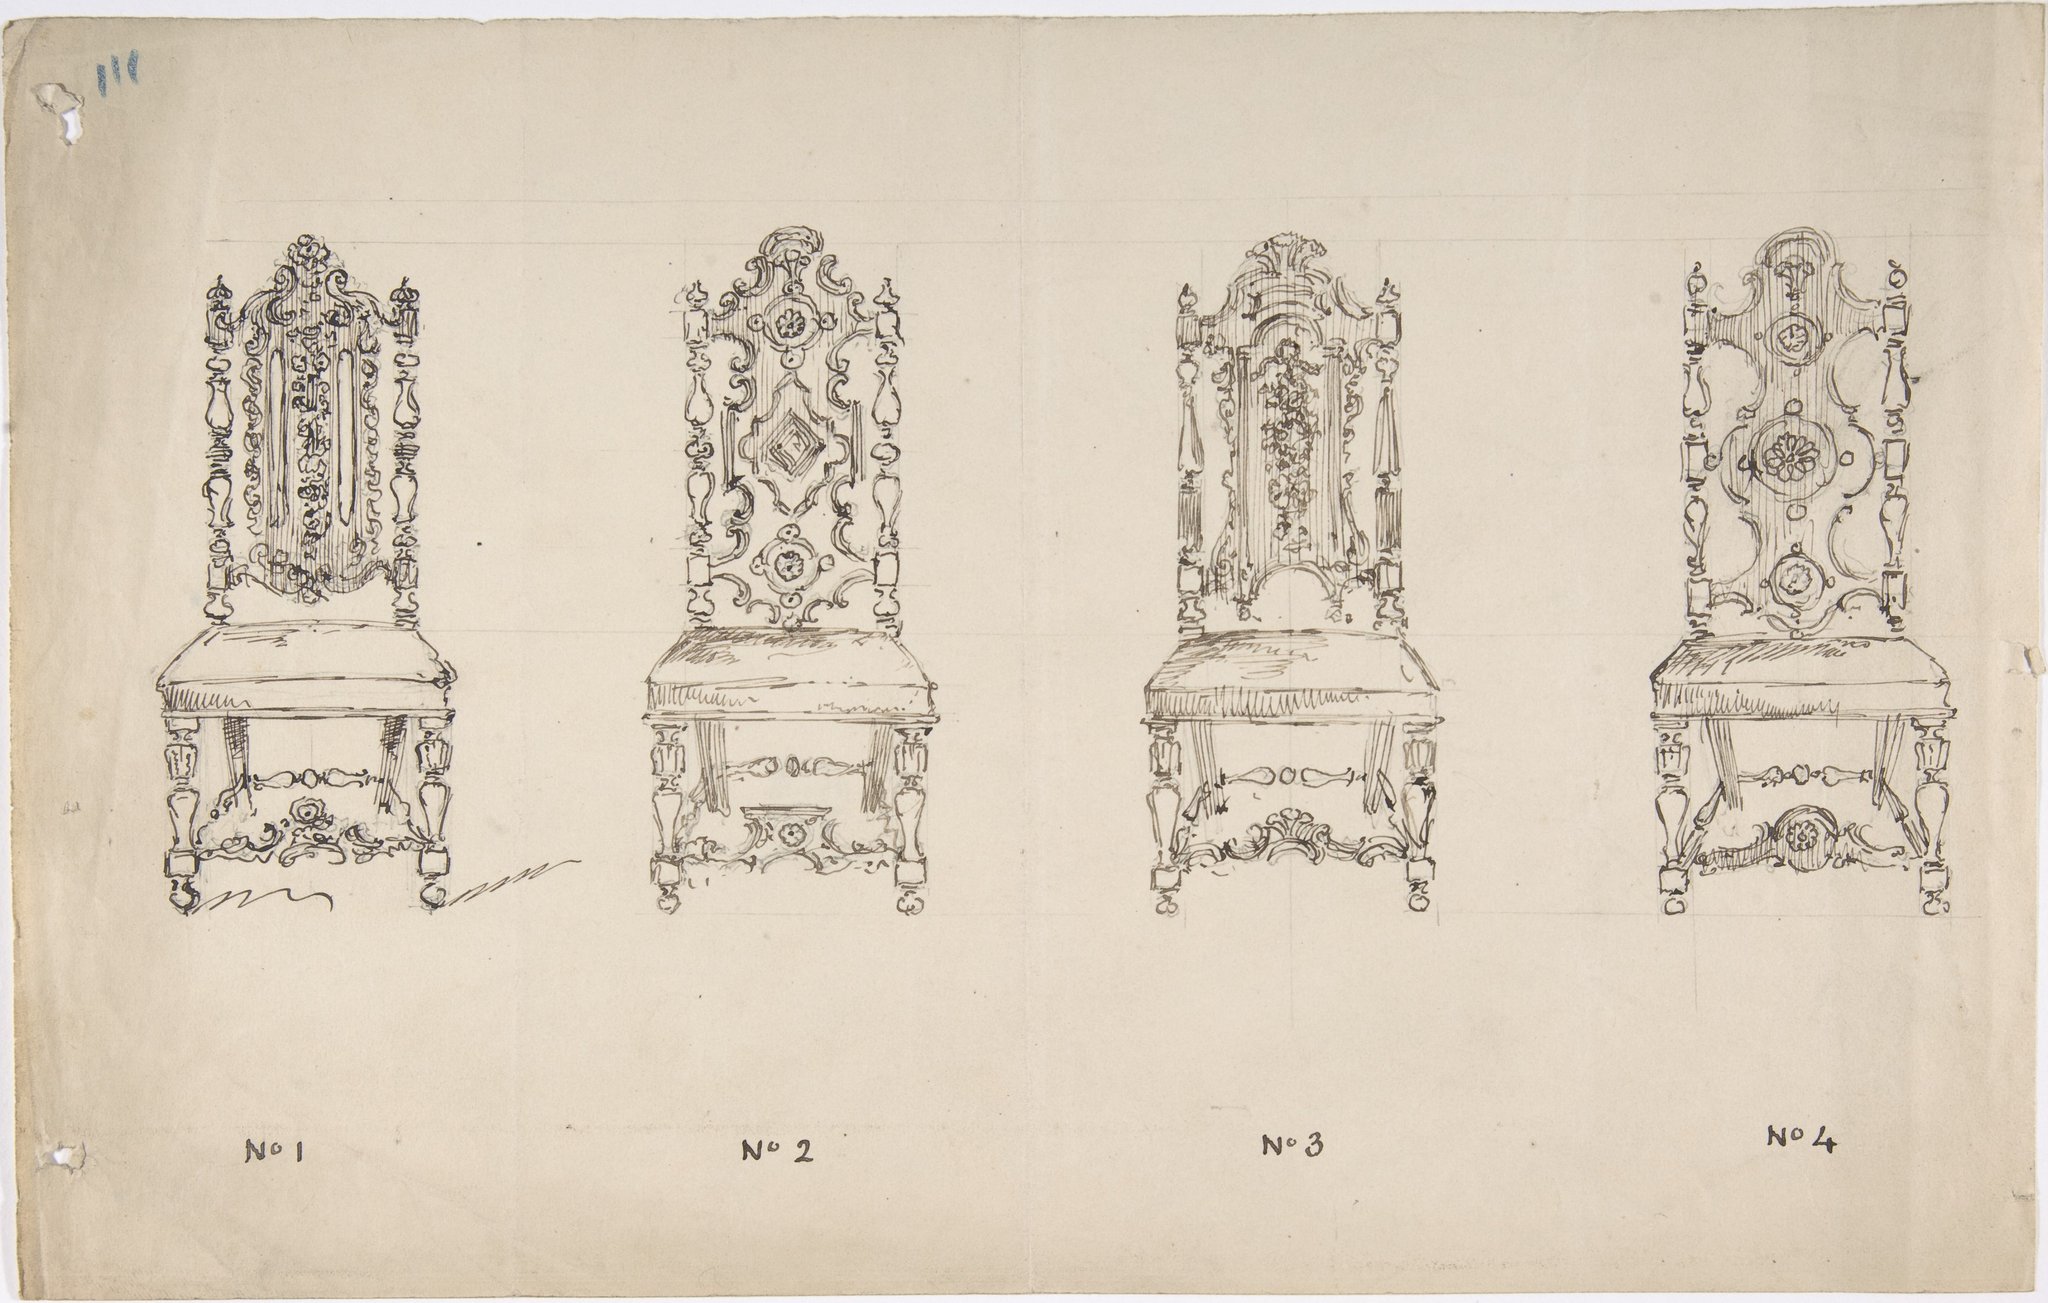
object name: drawing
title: Design for Four Seventeenth Century Style Chairs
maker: anonymous, british, 19th century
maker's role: artist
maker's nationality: british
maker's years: 1800-1900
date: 1801-1833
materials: ink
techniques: pen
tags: chairs